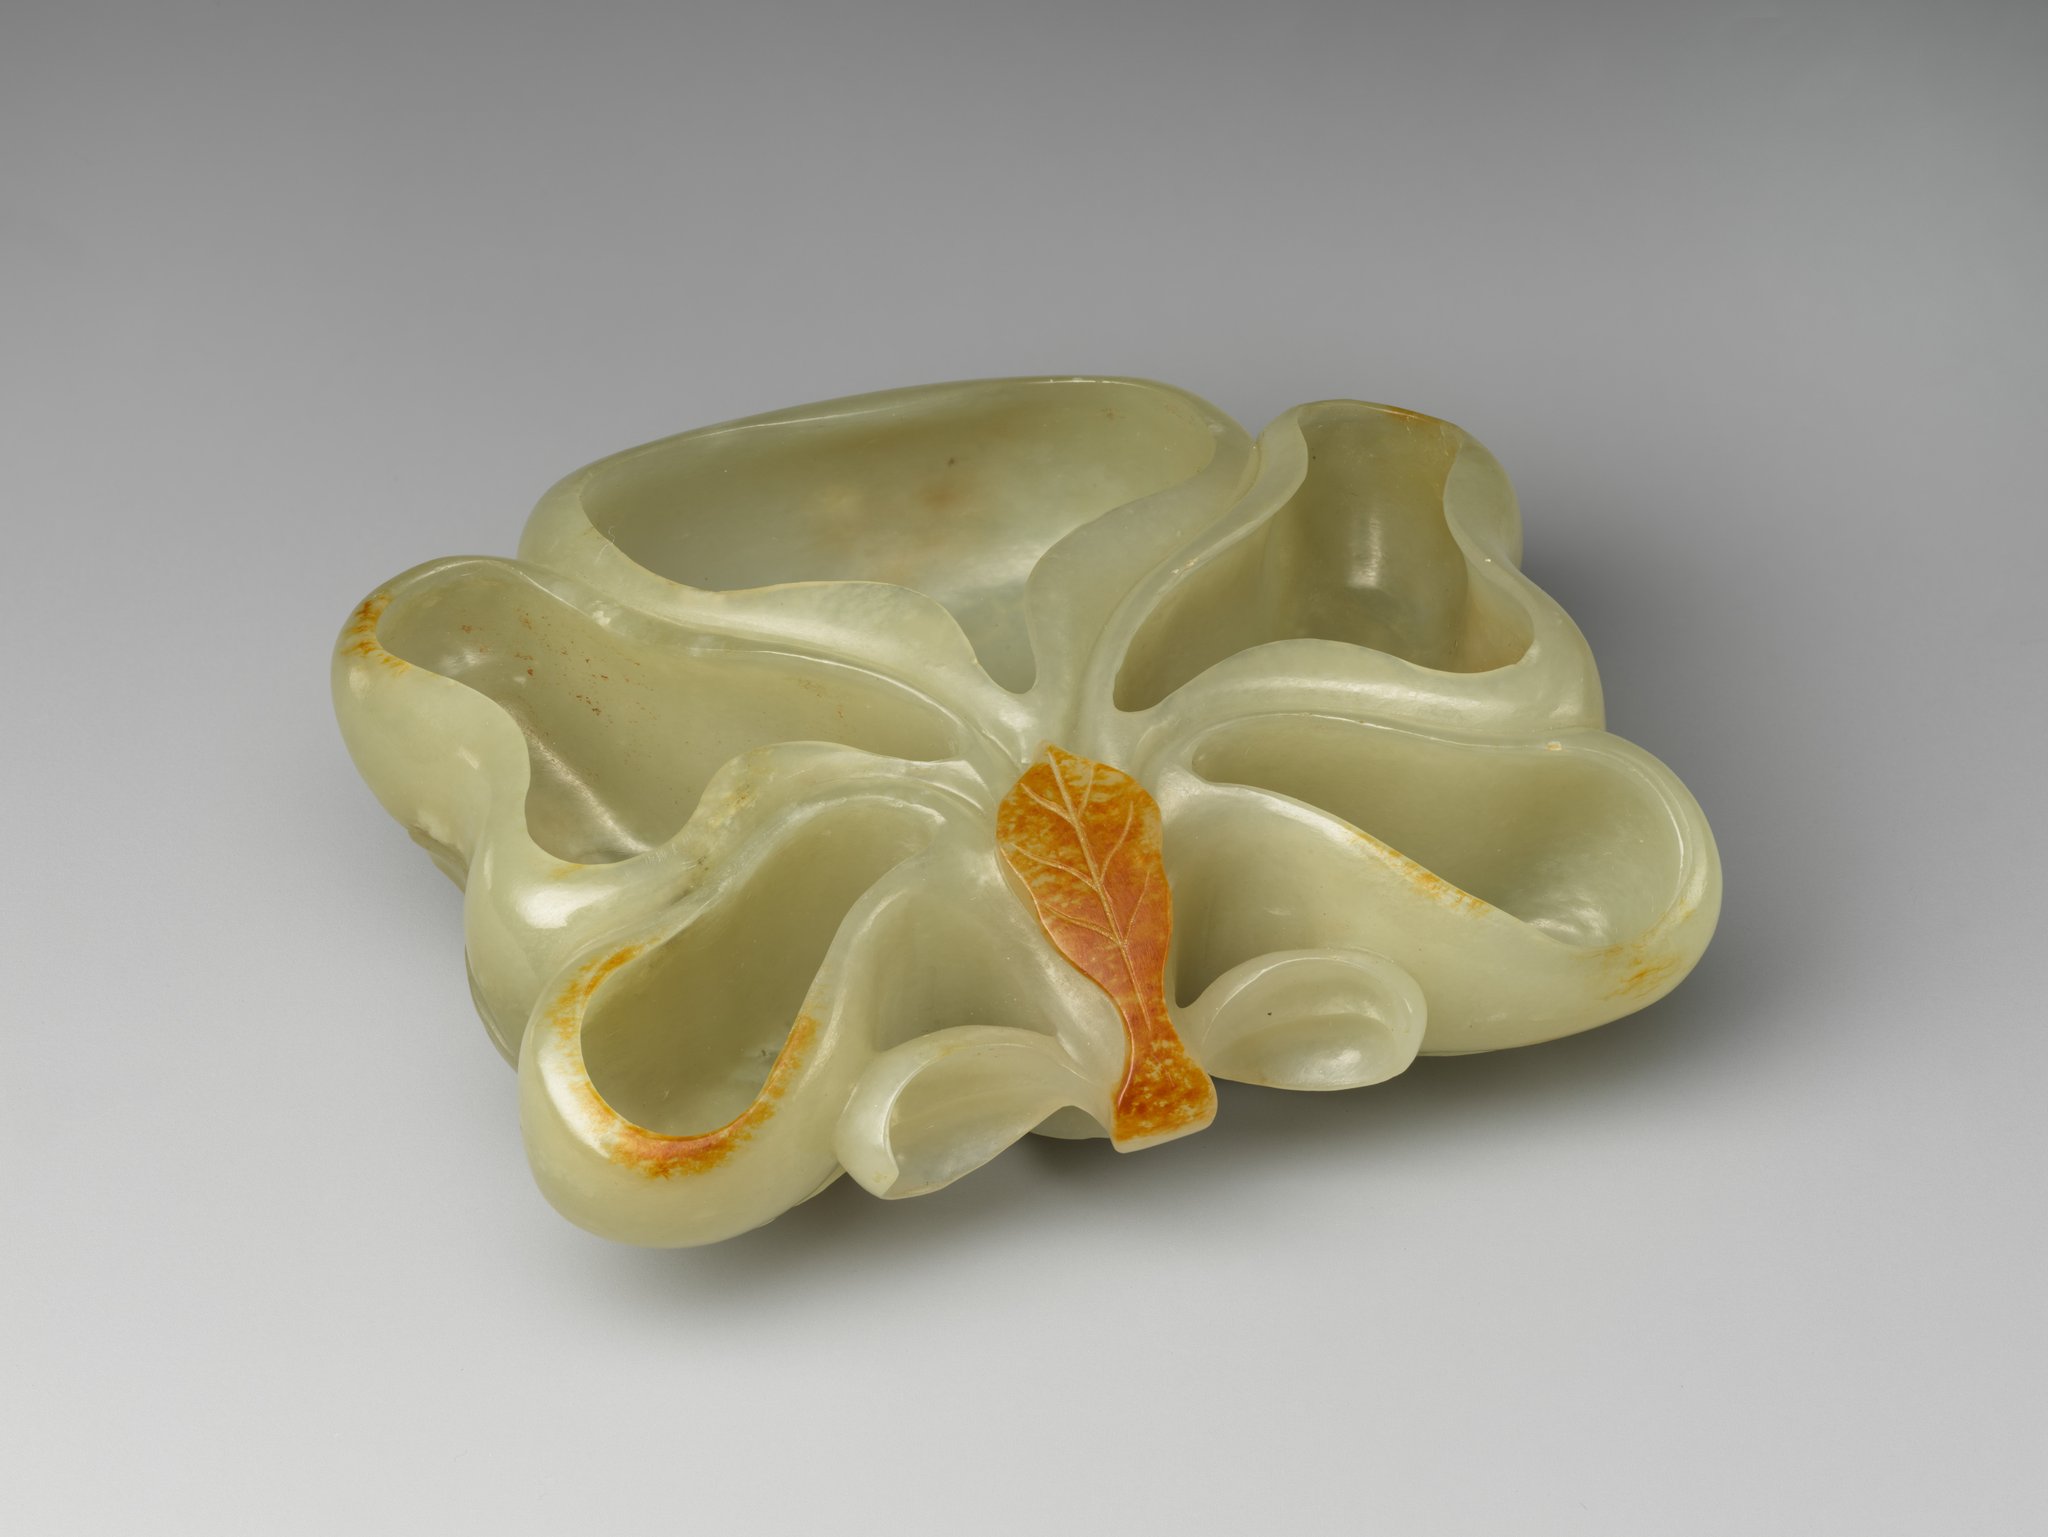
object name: water coupe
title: Water coupe in the form of a flower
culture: chinese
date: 1701-1800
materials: jade